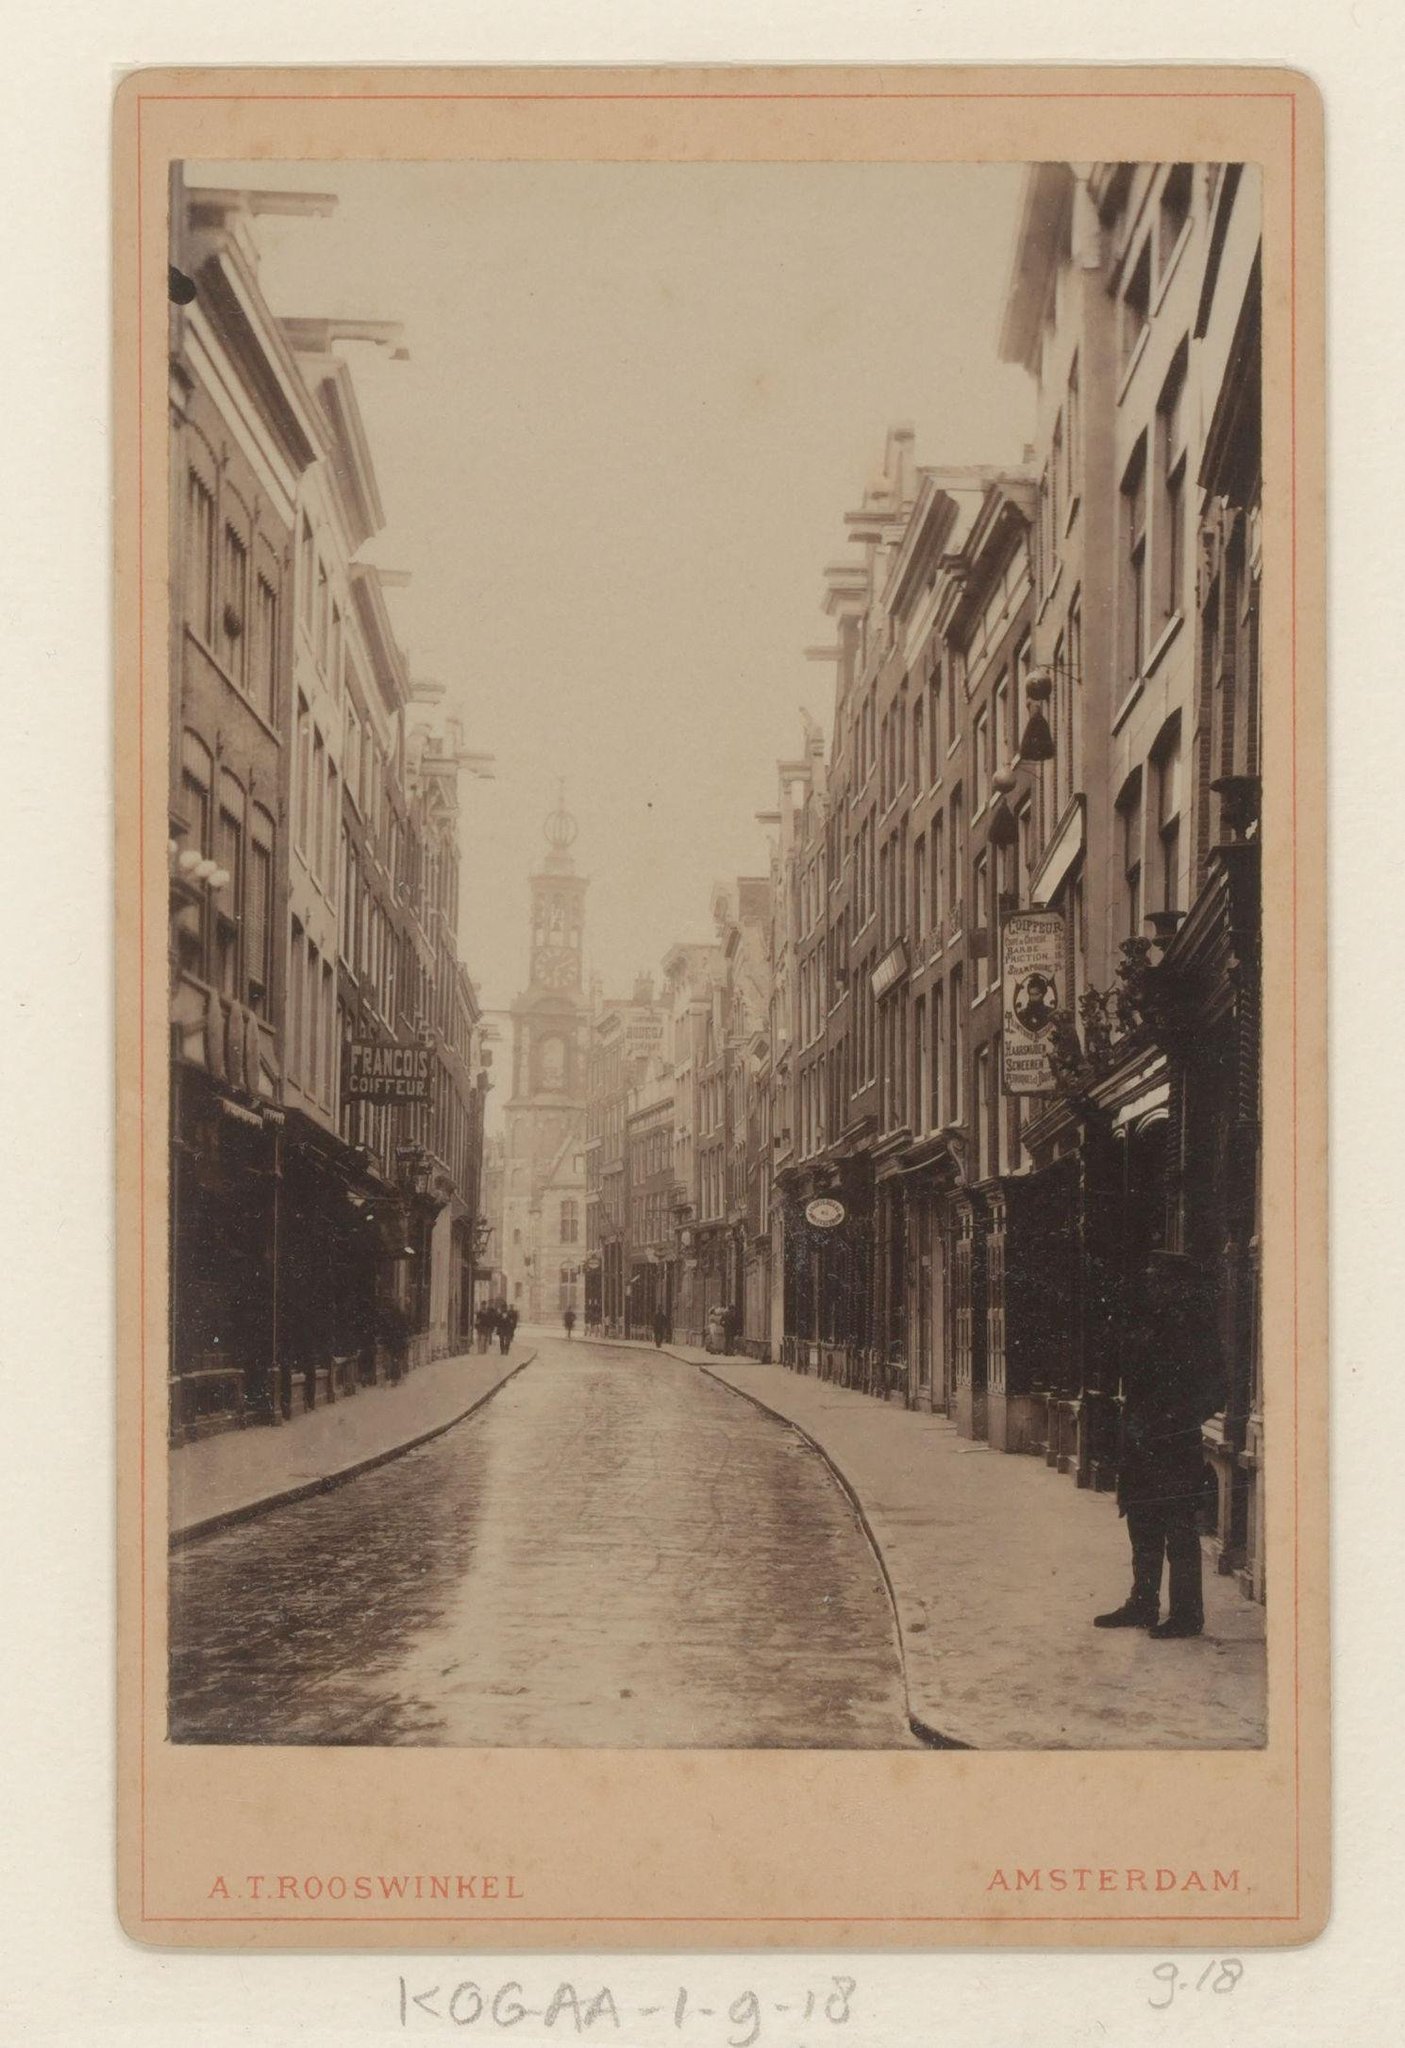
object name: cabinet photograph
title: Gezicht op de Kalverstraat en de Munttoren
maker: andreas theodorus rooswinkel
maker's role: fotograaf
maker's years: 1838-1909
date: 1875-1896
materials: cardboard, paper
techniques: albumen print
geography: amsterdam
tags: tower, clock tower ~ monumental adornment, city-view in general; 'veduta', street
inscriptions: inscription: ‘Kalverstraat bij de Munt. 38.’, stamp: ‘Gebr. Douwes / Atelier / Grimburgwal 15 / Amsterdam’, collector's mark: ‘9,18’ Lugt 1641b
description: Onderwerpsrubriek binnen de Atlas Amsterdam: Kadijksplein, Karthuizerkerkhof, Kattegat, Kattenburg, Kapelsteeg O.Z., Enge Kerksteeg, Kerkstraat, Kinkerstraat, Kolk O.Z., Koningsplein, Kromboomsloot [Krom Boomssloot], Kostverlorenkade, Kwakersdwarspad, Kalverstraat, Keizersgracht (v.d. Brouwersgracht – Amstel), Klerensloot (Gedempte), Klimopstraat, Kloveniersburgwal, Kraansluis.